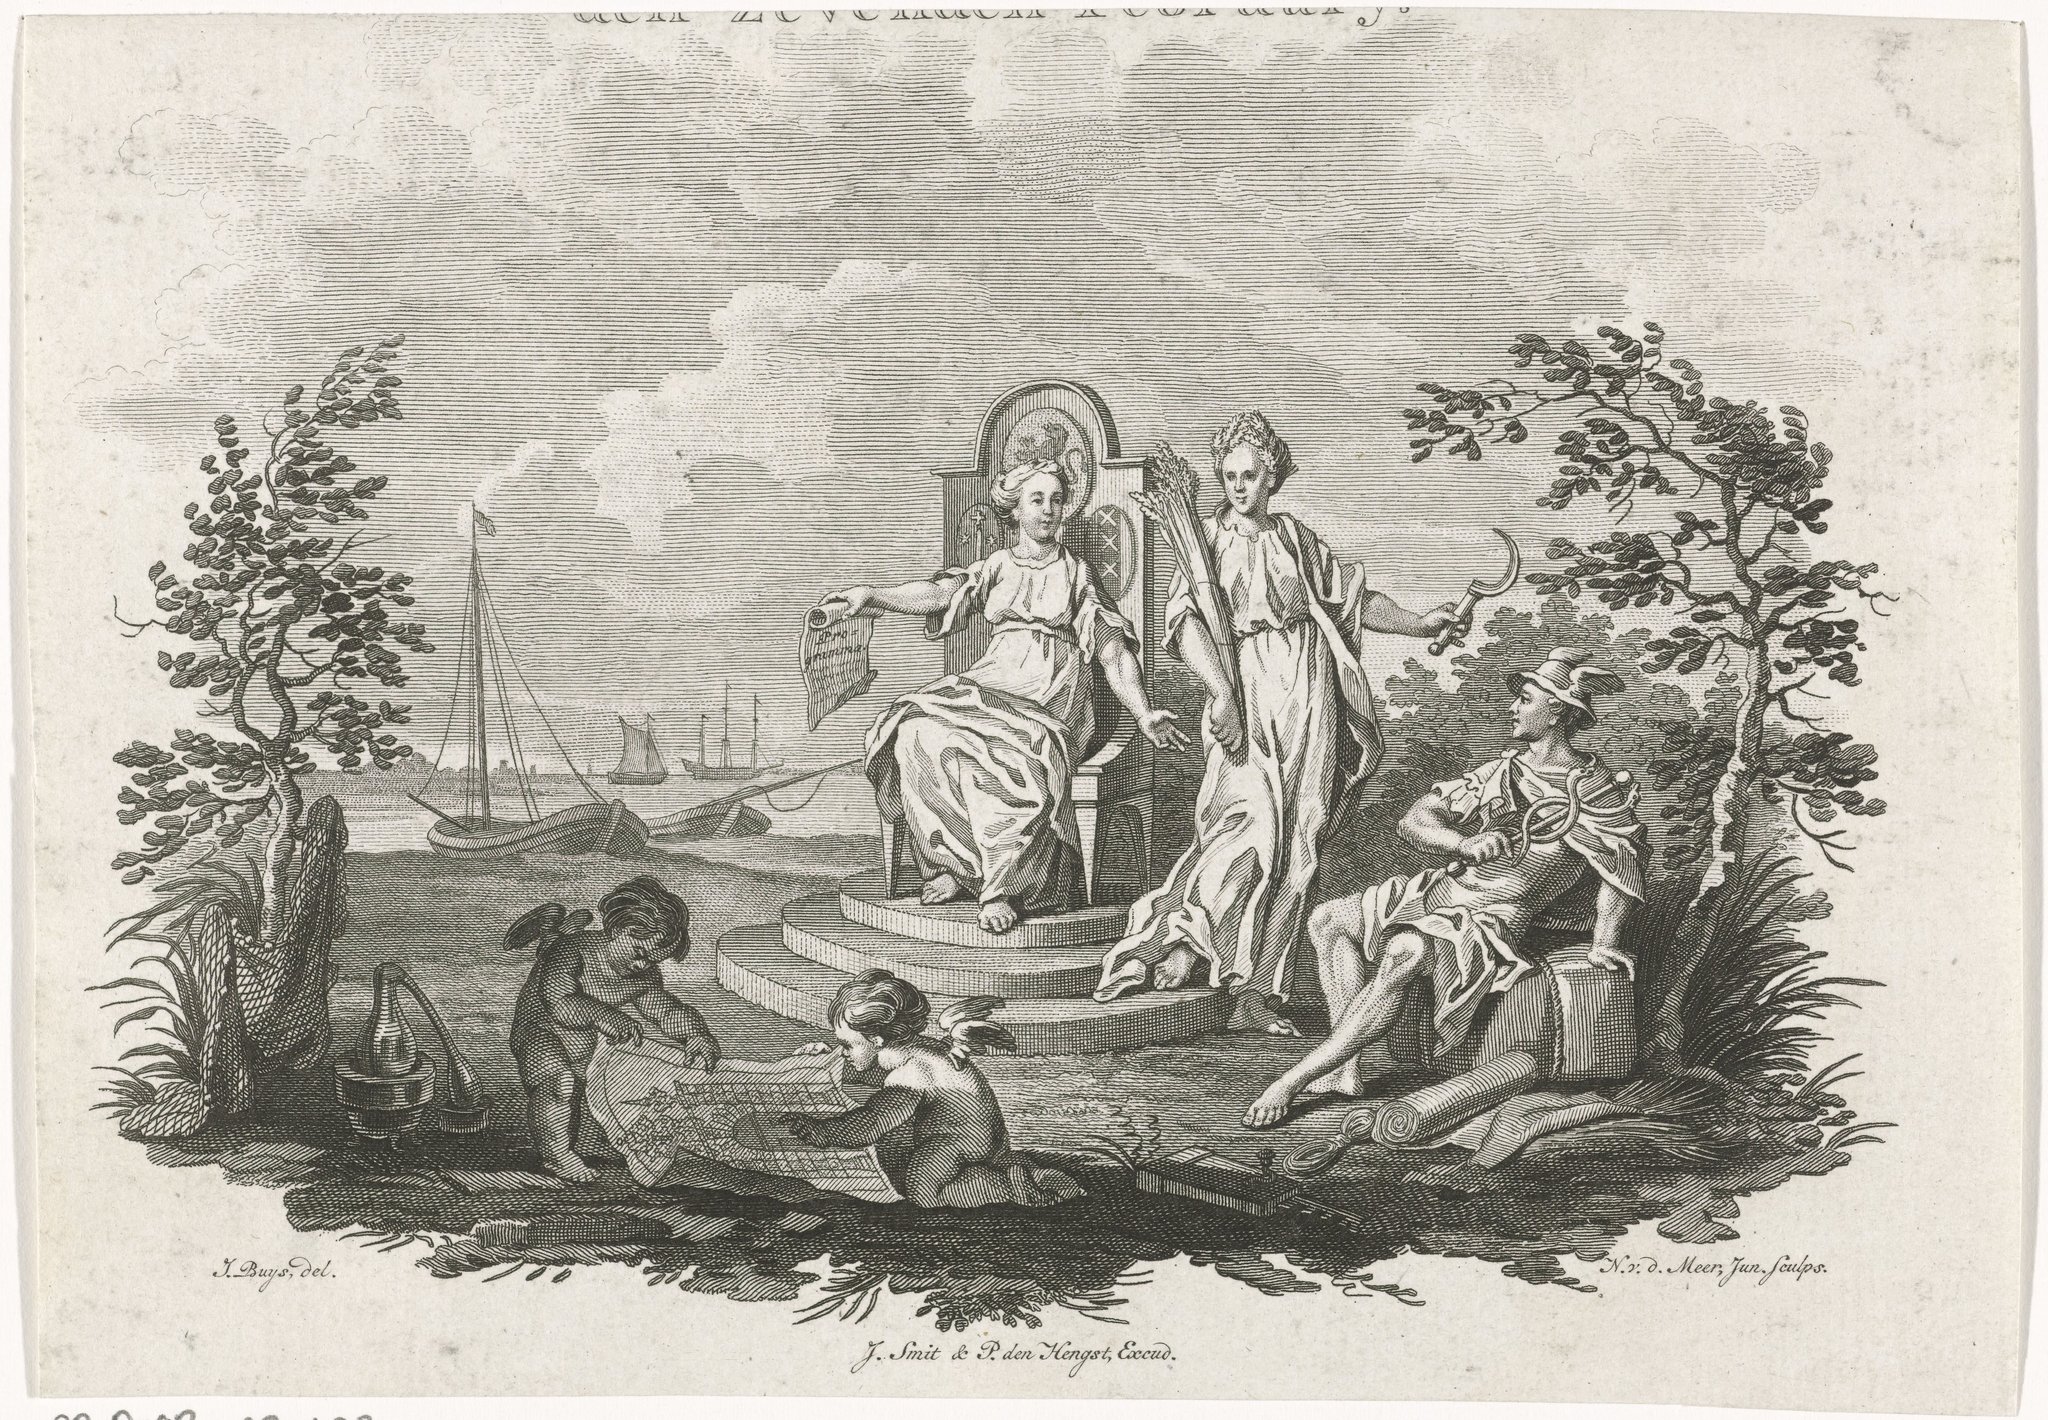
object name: print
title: Allegorie op de eerste vergadering van de in 1777 opgerichte 'Oeconomische Tak' van de Hollandse Maatschappij der wetenschappen te Haarlem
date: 1777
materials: paper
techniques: etching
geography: amsterdam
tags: (story of) ceres (demeter), (story of) mercury (hermes), cupids: 'amores', 'amoretti', 'putti'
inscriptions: collector's mark: Lugt 2228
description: De gepersonifieerde Hollandse Maatschappij der Wetenschappen is gezeten op een troon, waarop de stadswapens van Haarlem en Amsterdam zijn aangebracht. Bij de troon staat Ceres, godin van de landbouw, met een korenschoof en een sikkel. Rechts de zittende Mercurius met de caduceus in zijn hand. Op de voorgrond buigen twee putti zich over een bouwtekening. Op de achtergrond schepen op het water. Allegorie op de eerste vergadering van de in 1777 opgerichte 'Oeconomische Tak' van de Hollandse Maatschappij der wetenschappen te Haarlem. Deze tak van de Maatschappij had tot doel door middel van jaarlijkse prijzen handel en bedrijf uit hun verval op te heffen.